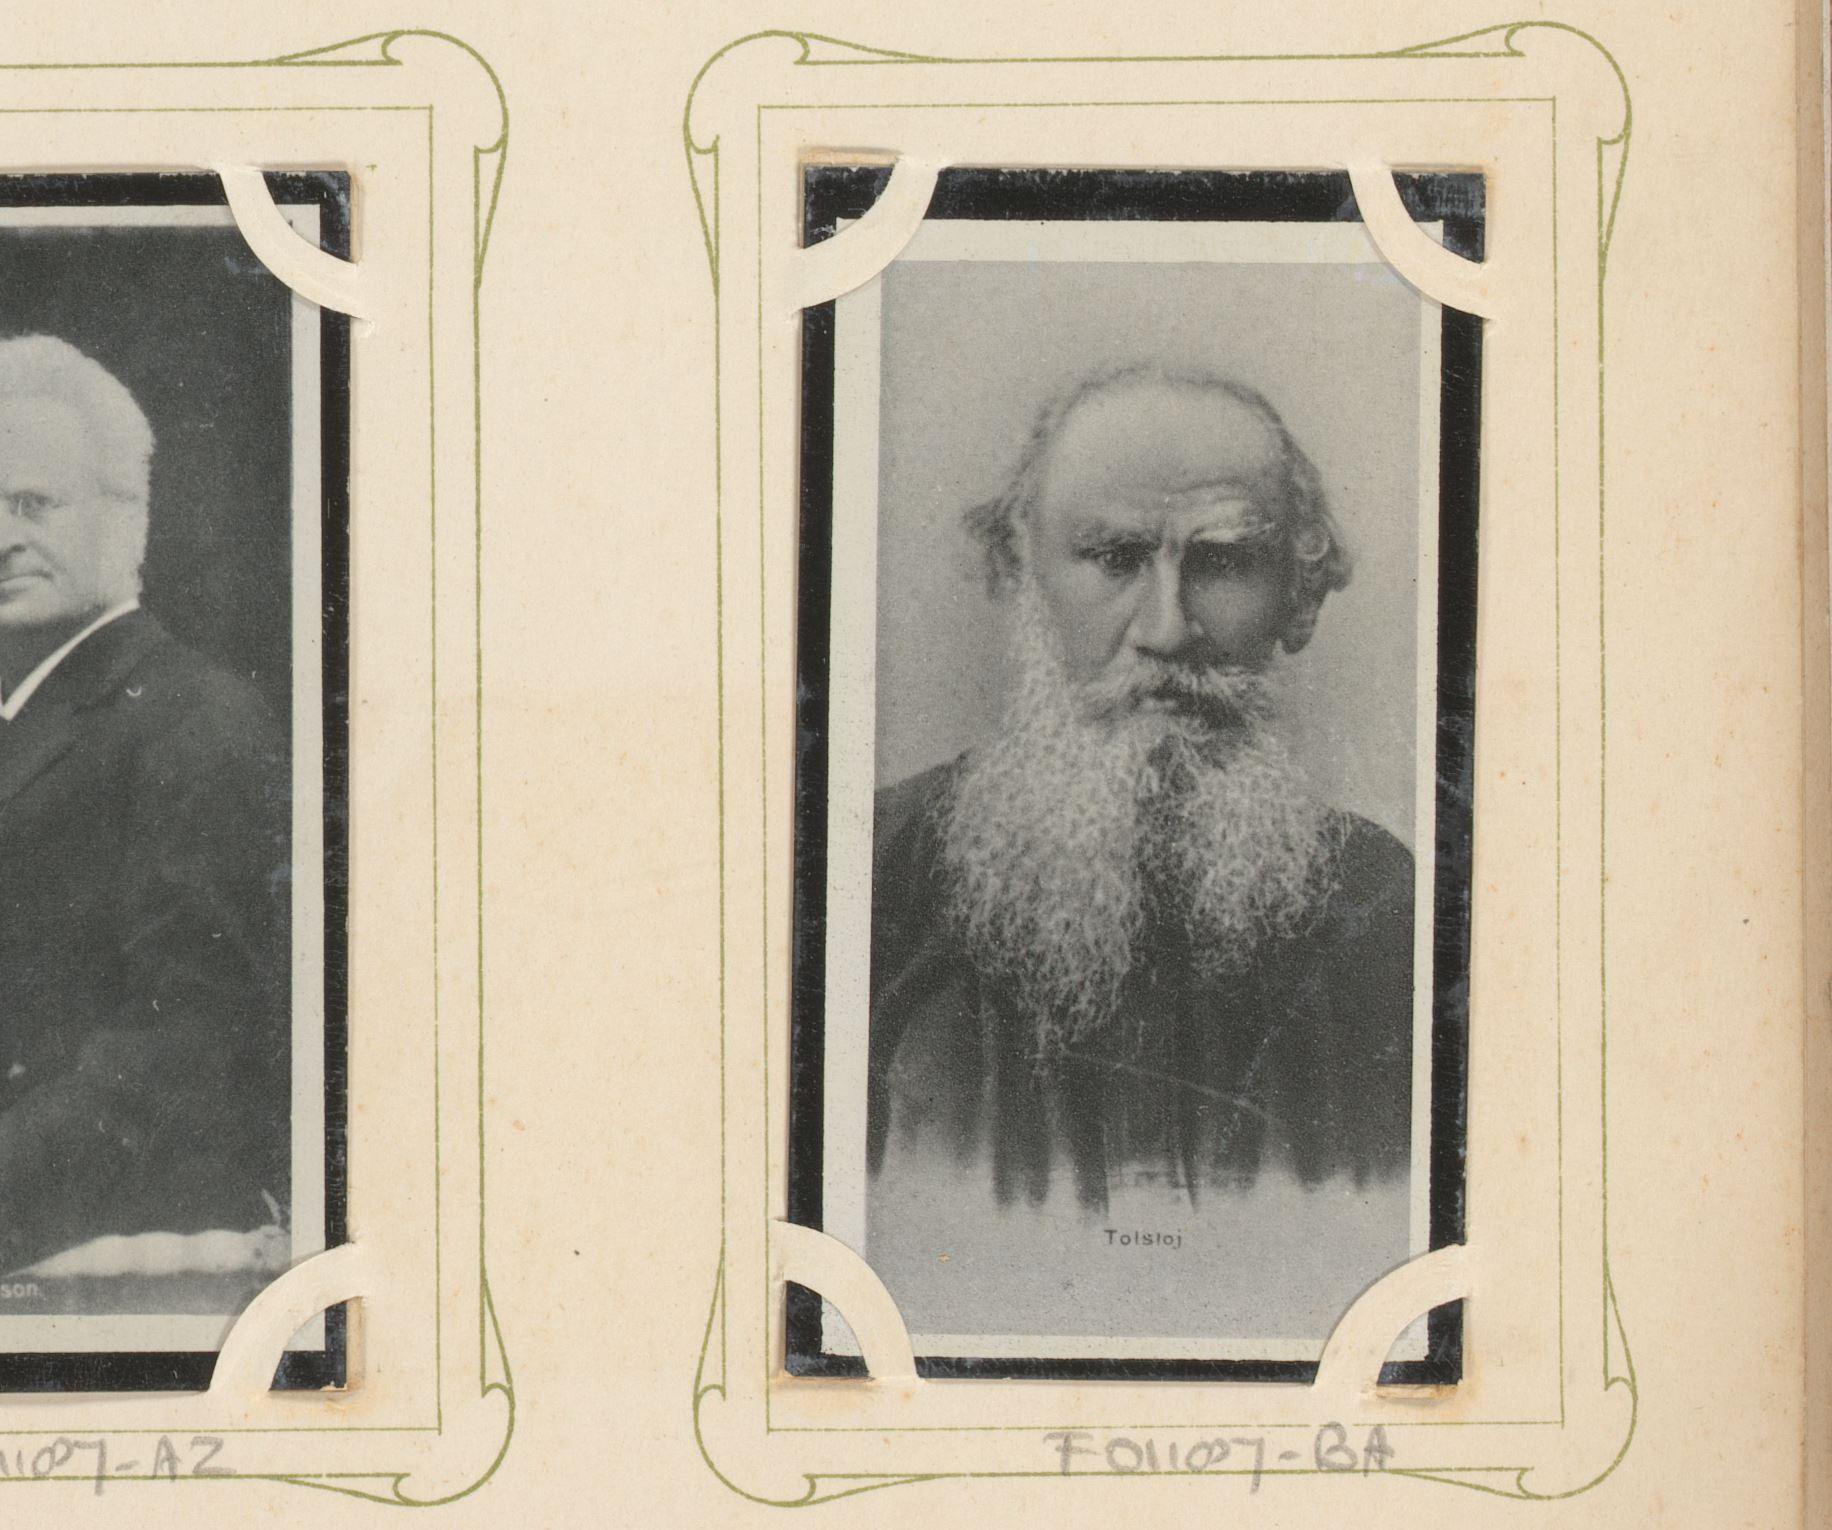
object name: photomechanical print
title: Portret van Leo Tolstoj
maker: Anonymous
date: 1905-1906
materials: paper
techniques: photograph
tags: lev tolstoj, historical persons, portrait of a writer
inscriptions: inscription: ‘No. 6./ Tolstoy.’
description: Deze prent maakt deel uit van een album.